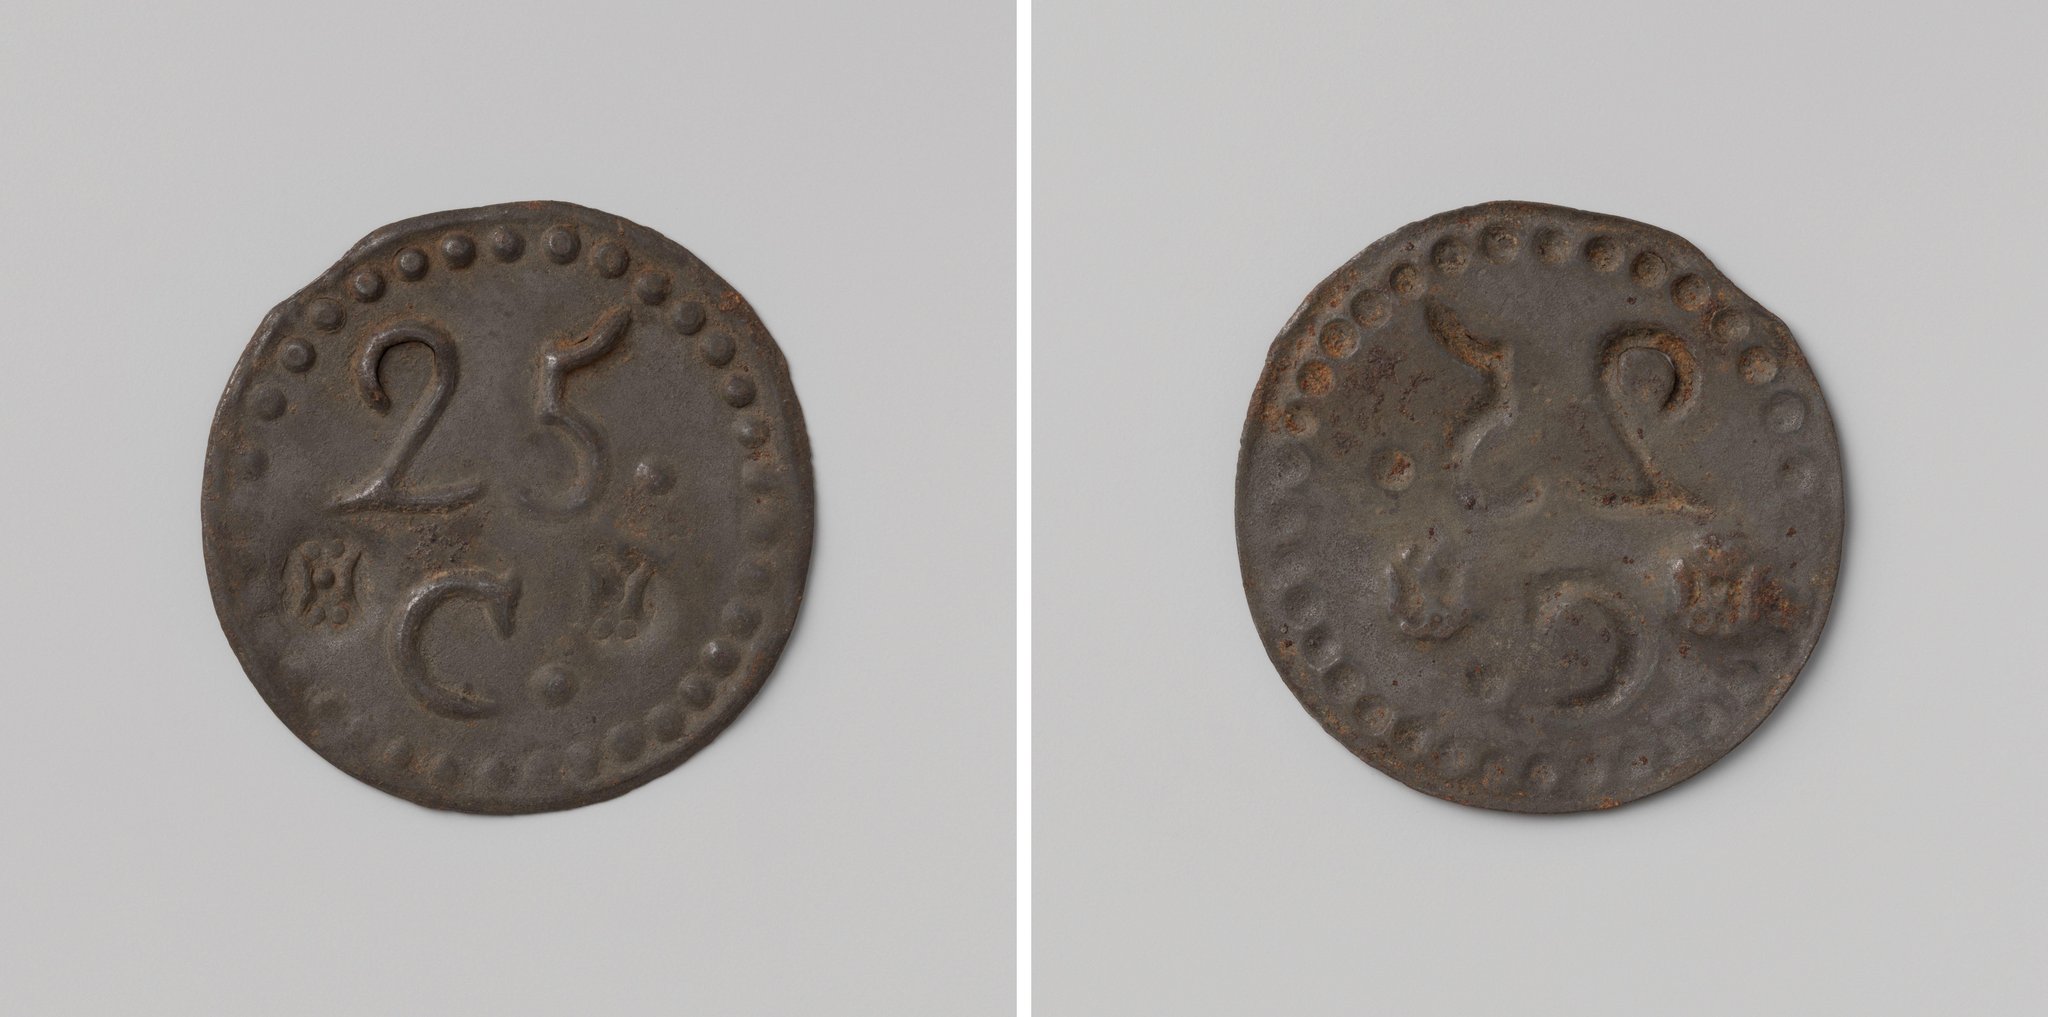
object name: monetary token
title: Strafgevangenis Ommerschans, huismunt geslagen op last van de Maatschappij van Weldadigheid ter waarde van 25 cent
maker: Anonymous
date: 1822-1830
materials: metal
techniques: striking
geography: ommerschans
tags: maatschappij van weldadigheid, ommerschans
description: eenzijdige munt. Voorzijde: waardeaanduiding binnen parelrand; links en rechts: merk. Keerzijde: blanco